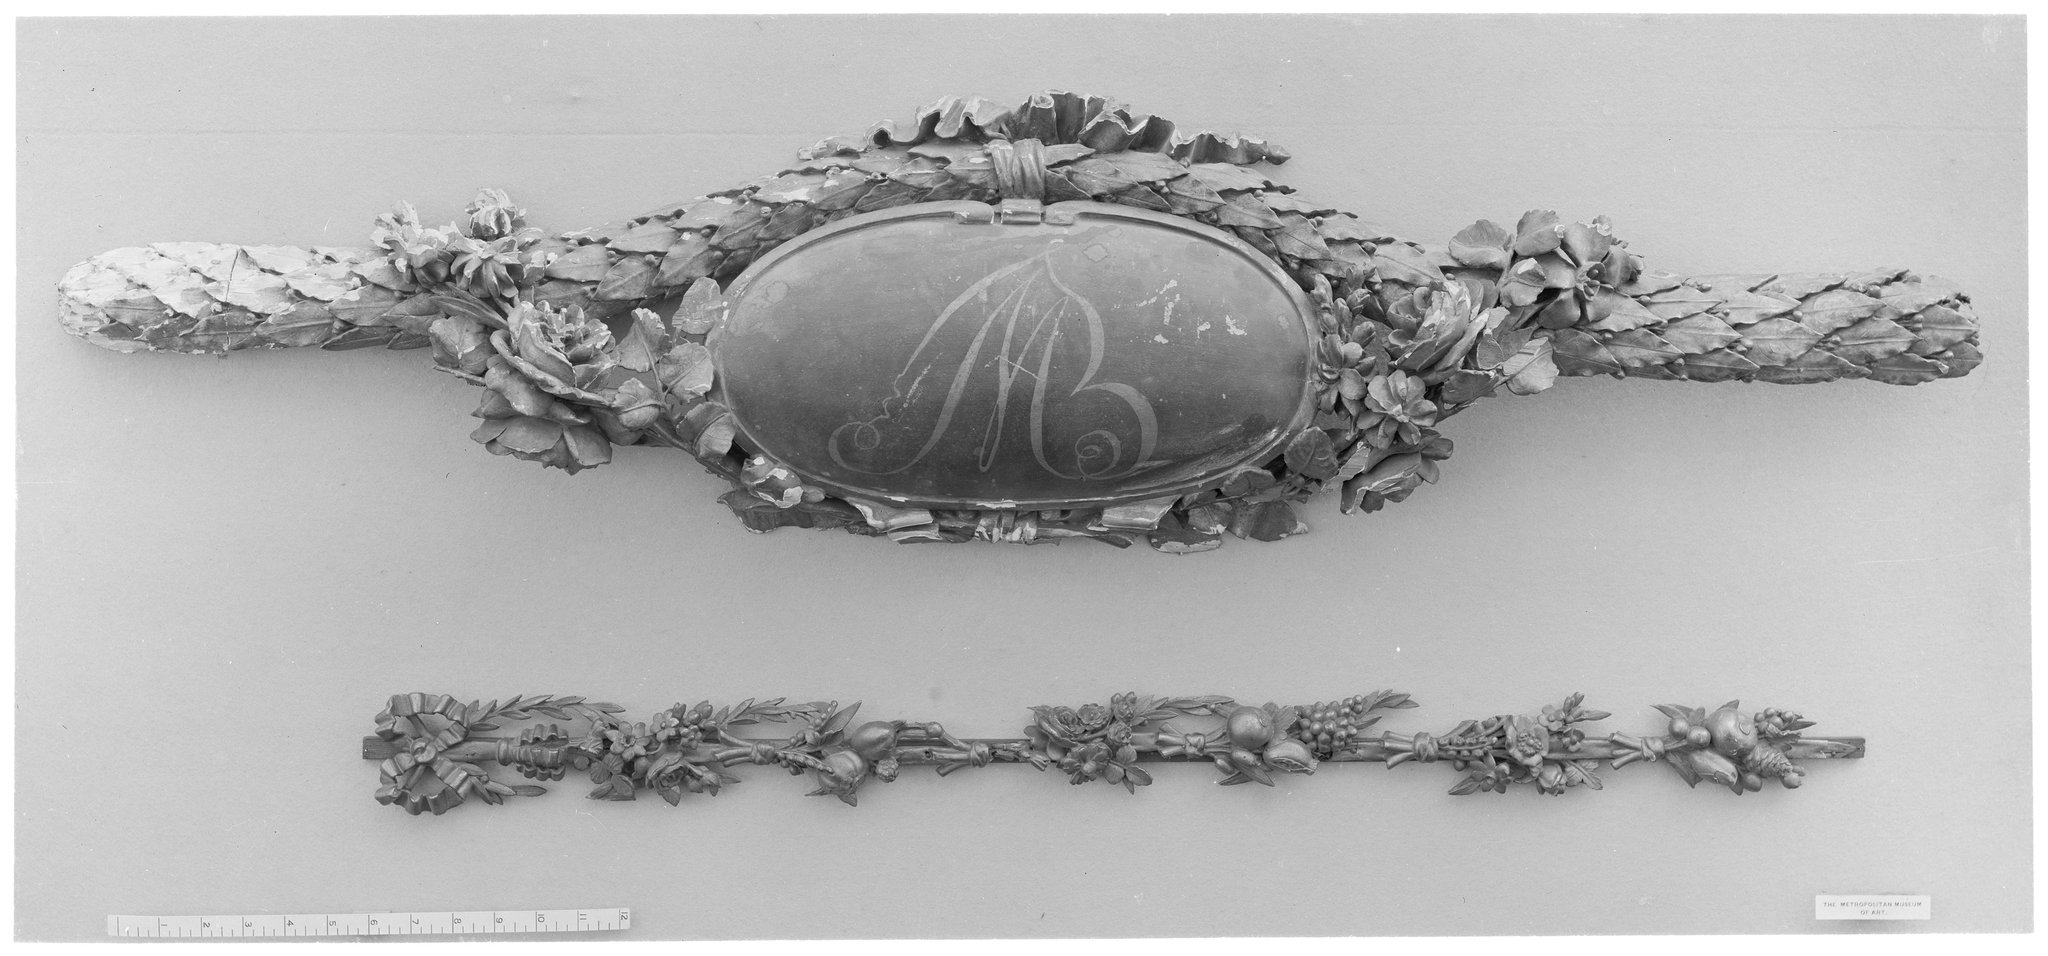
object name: fragment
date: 1701-1800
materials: gilt, wood